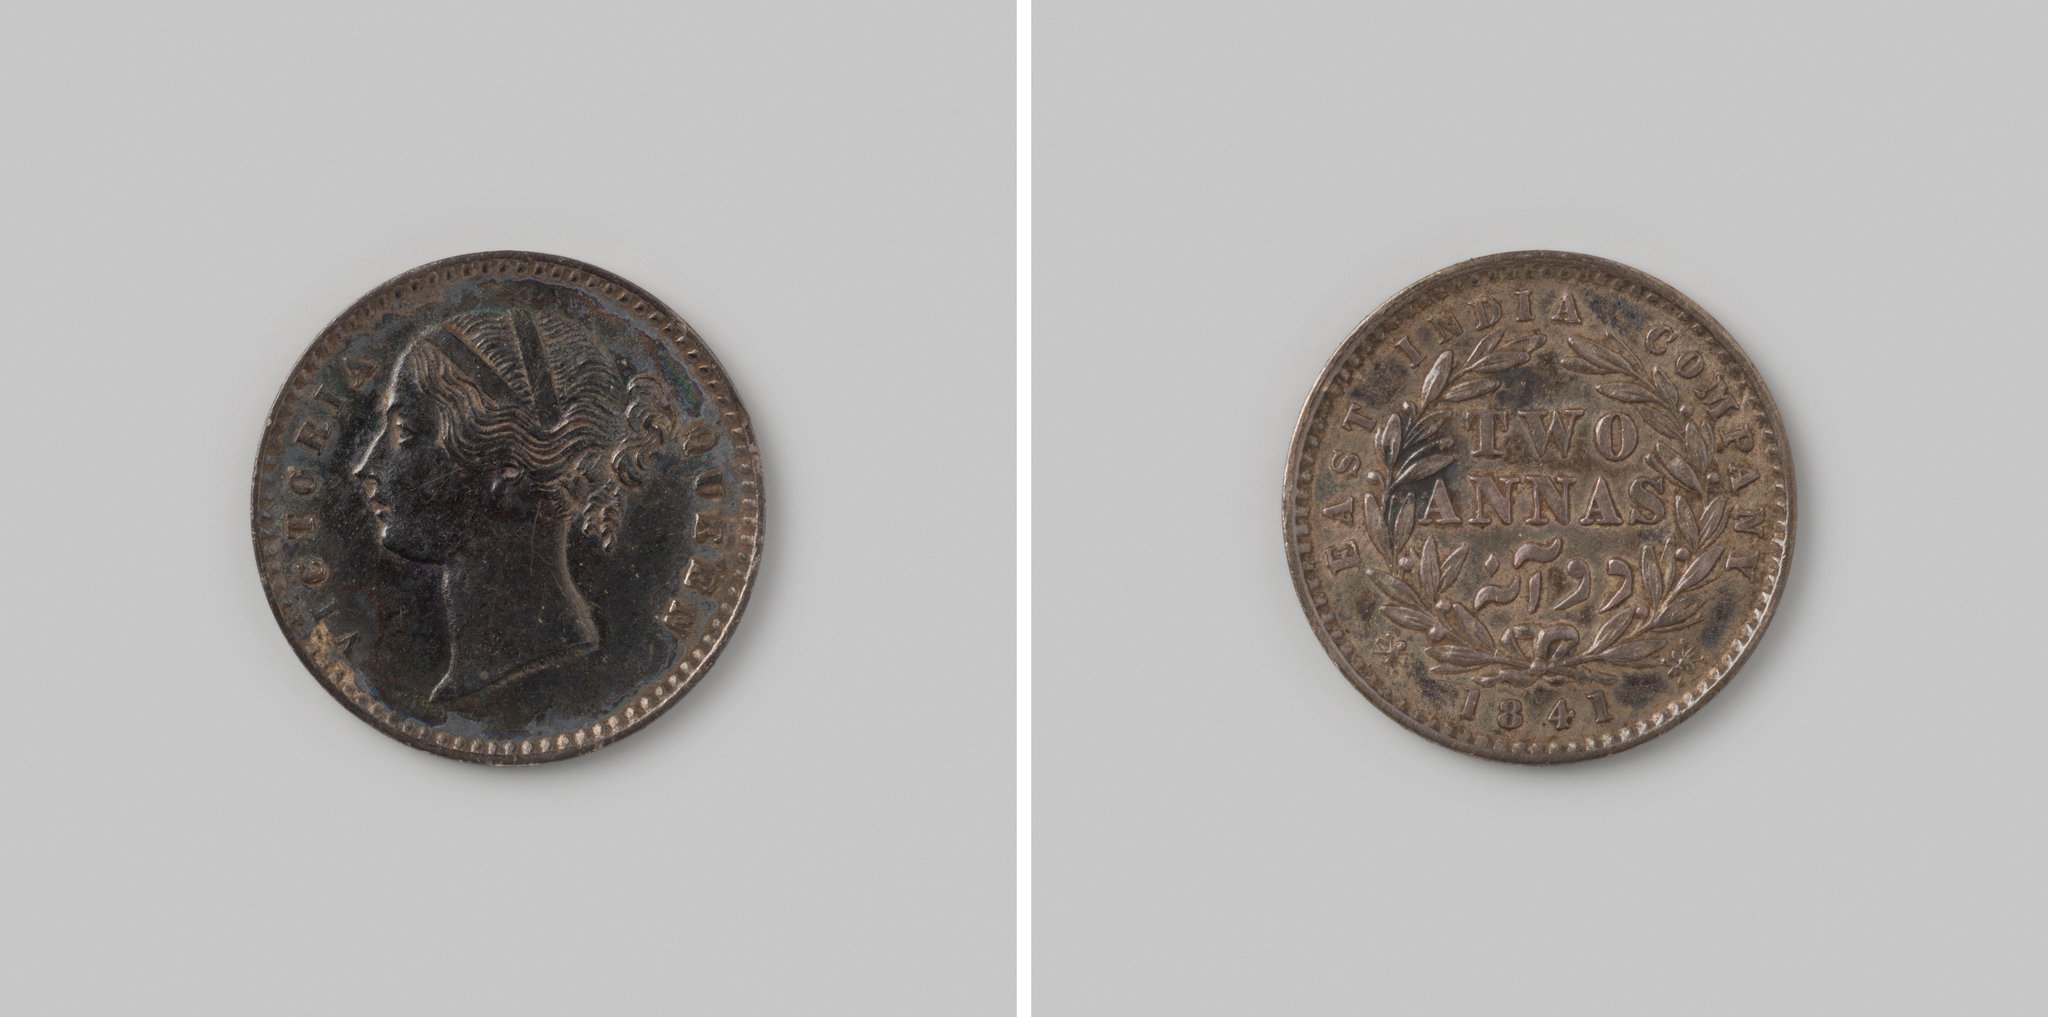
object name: coin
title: India, Engelse Oostindische Compagnie (EIC), op naam van koningin Victoria, 2 annas, 1841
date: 1841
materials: silver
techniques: striking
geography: mumbai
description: Zilveren munt. Voorzijde: hoofd van koningin Victoria naar links. Omschrift in twee gedeelten. Keerzijde: tussen twee samengebonden takken in twee regels waarde-aanduiding: two annas, waaronder in Arabische lettertekens in een regel waarde-aanduiding. Onderaan jaartal. Gladde rand.